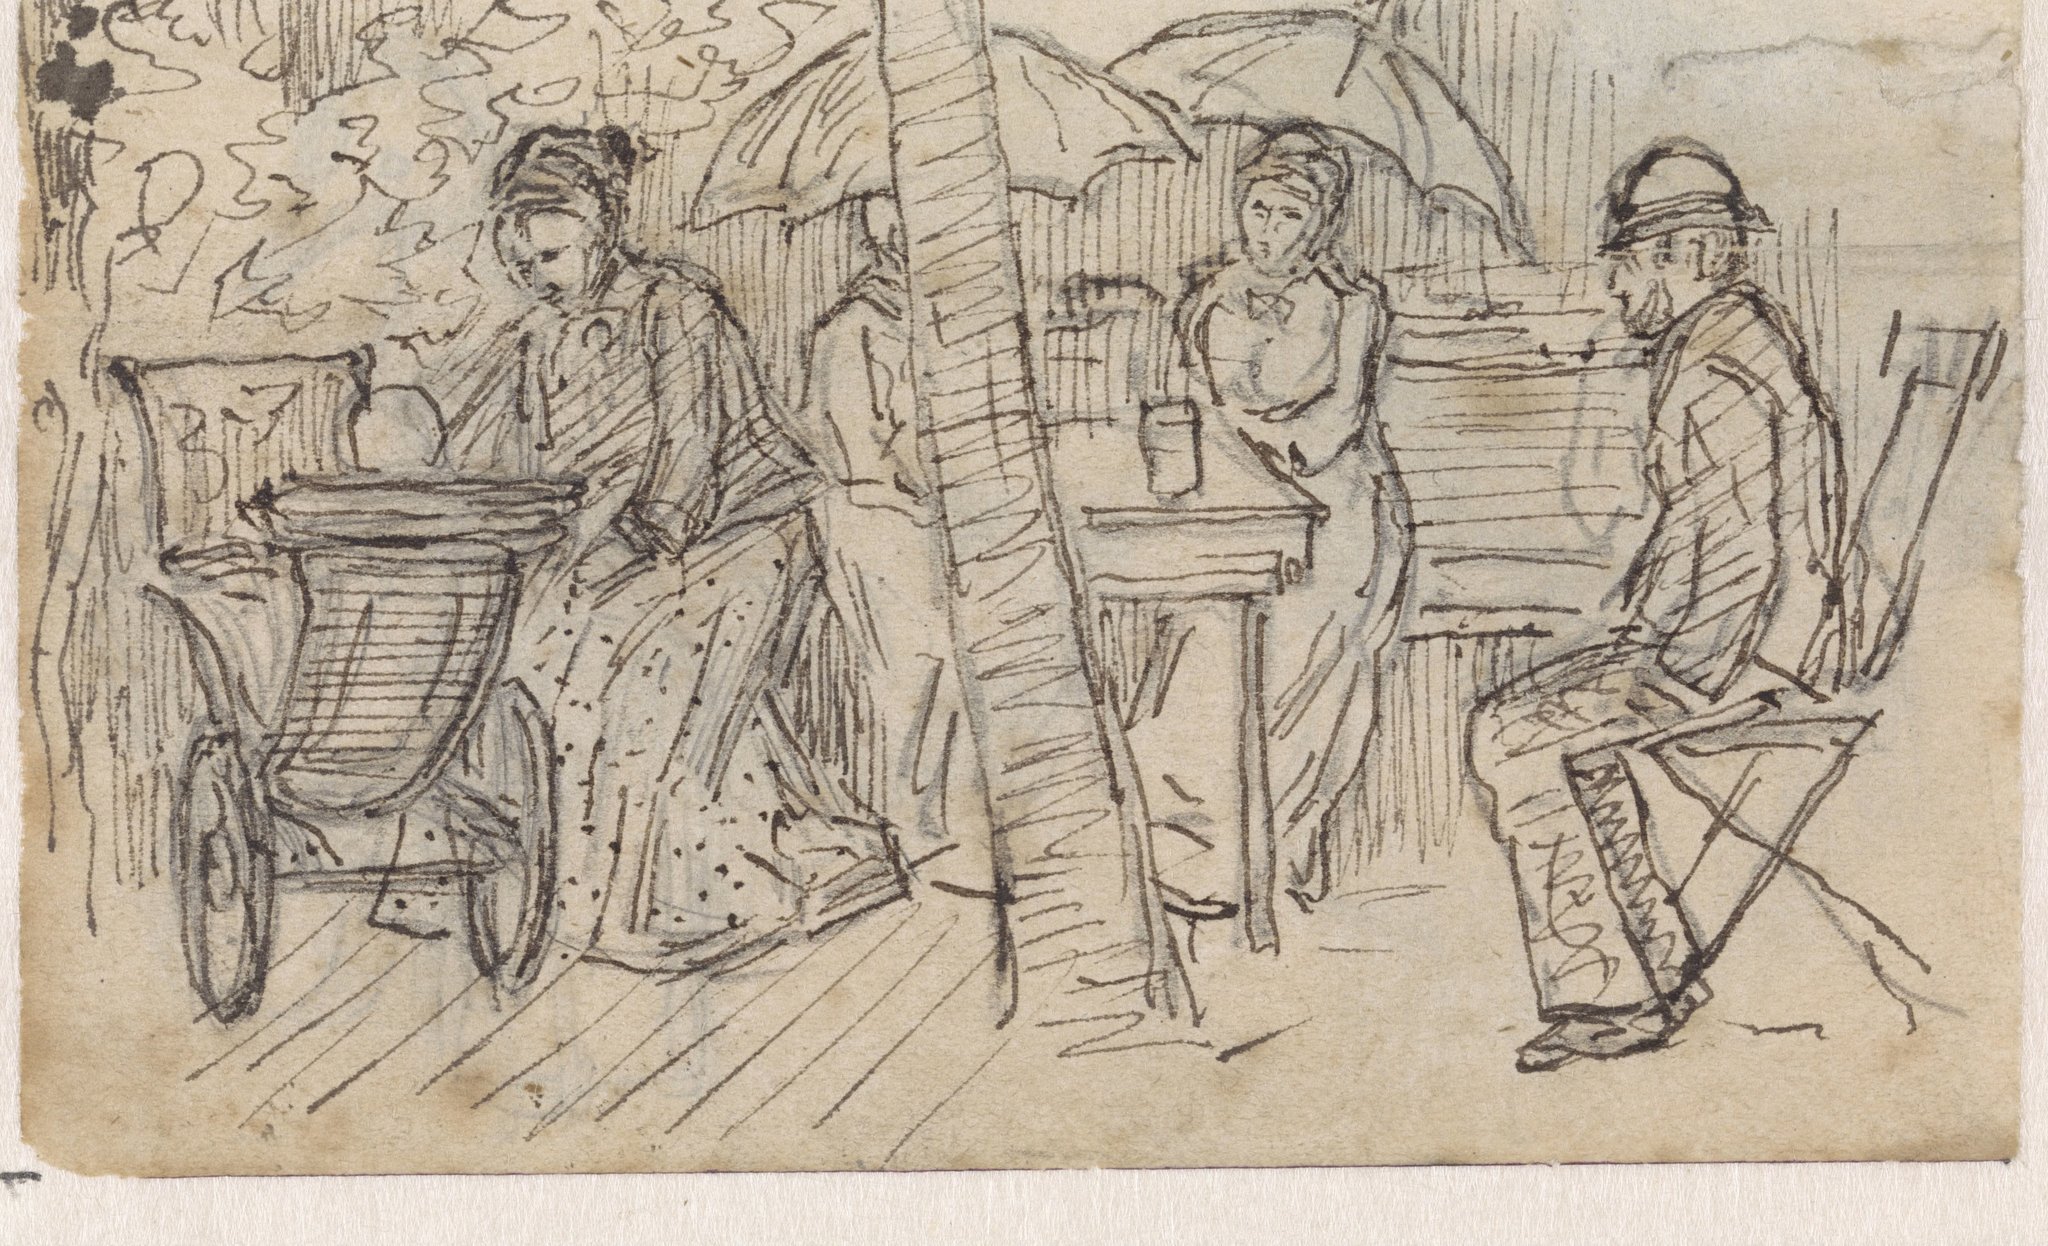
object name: drawing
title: Gezelschap met een kinderwagen rond een tafel onder een boom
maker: jan van essen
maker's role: draughtsman, print maker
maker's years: 1854-1936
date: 1864-1936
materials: ink, paper, pencil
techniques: pen